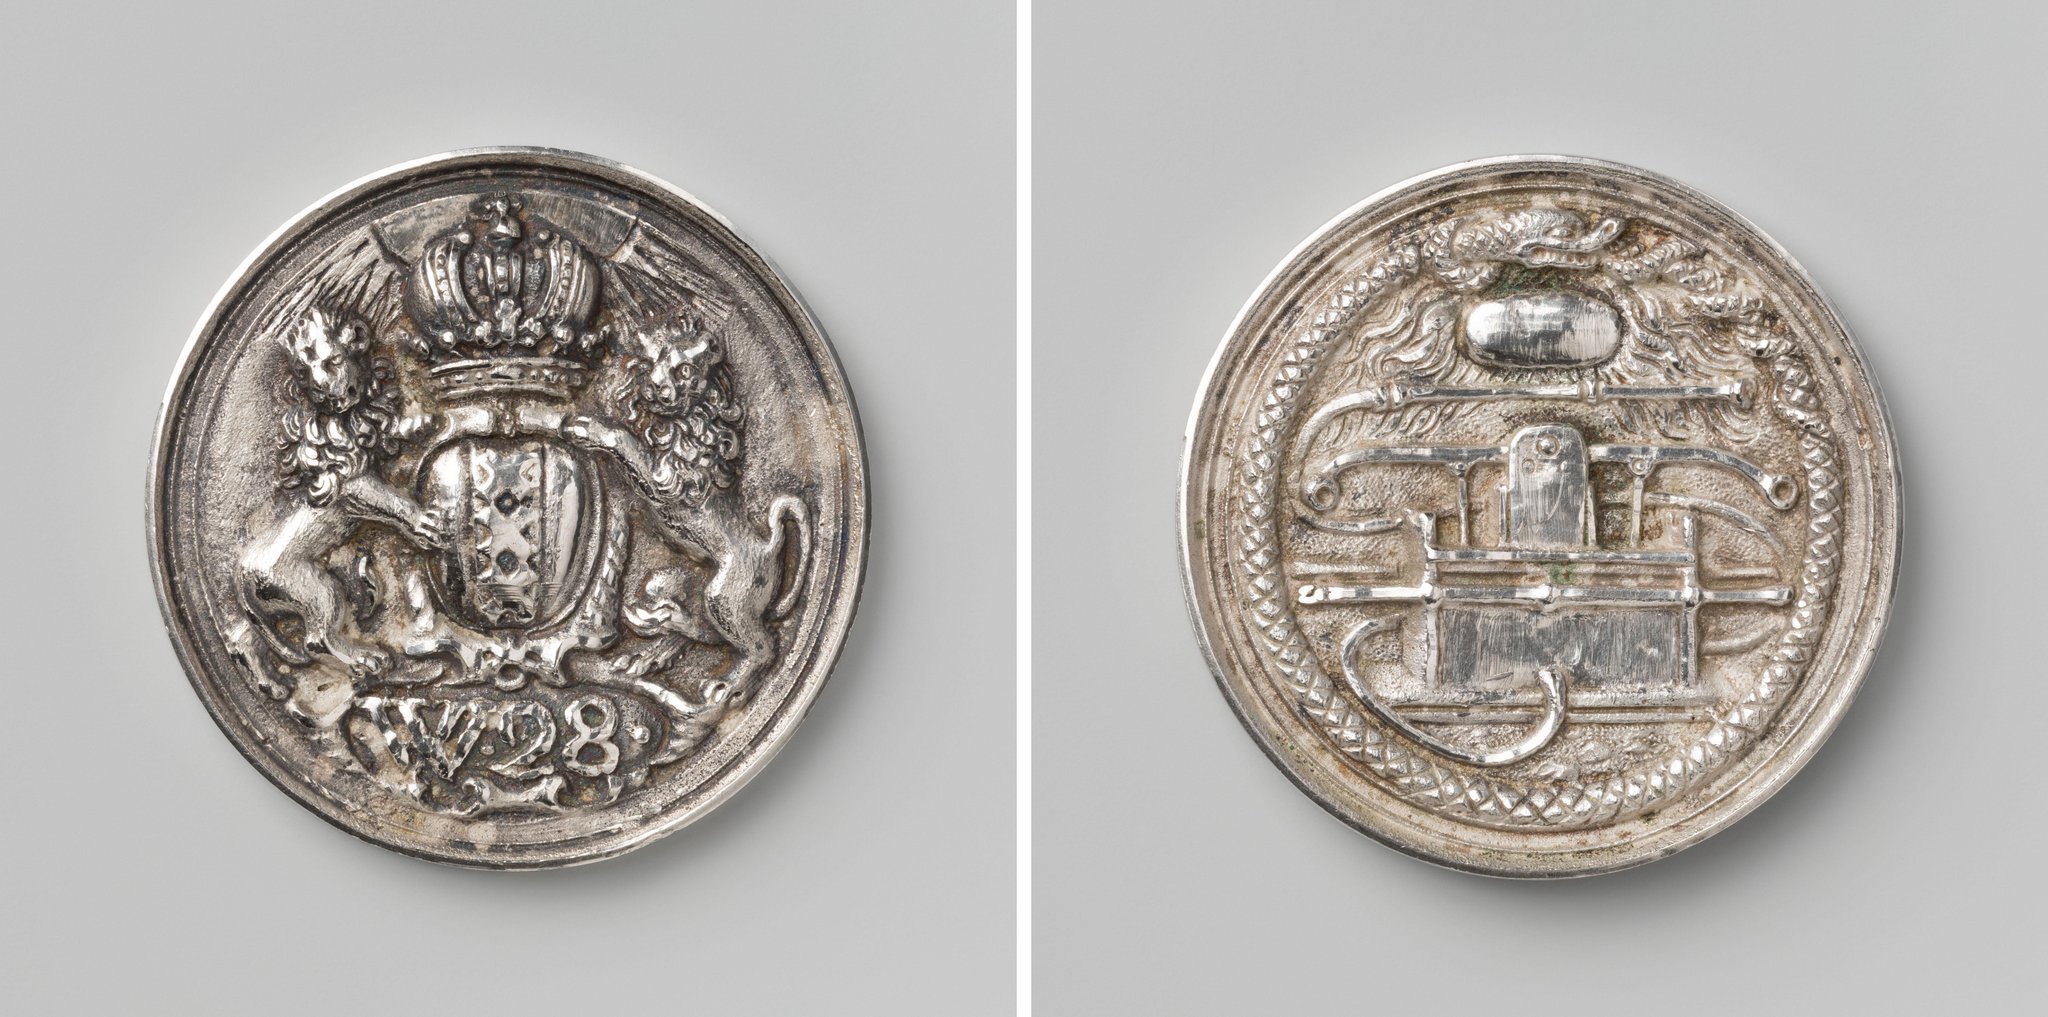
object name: medal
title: Amsterdam, brandspuitpenning van wijk 28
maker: Anonymous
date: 1680-1800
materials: silver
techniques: casting, engraving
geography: amsterdam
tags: amsterdam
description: Zilveren penning. Voorzijde: gekroond wapenschild, geflankeerd door twee leeuwen boven cartouche met opschrift W 28. Keerzijde: brandspuit onder leeg cartouche binnen slangerond